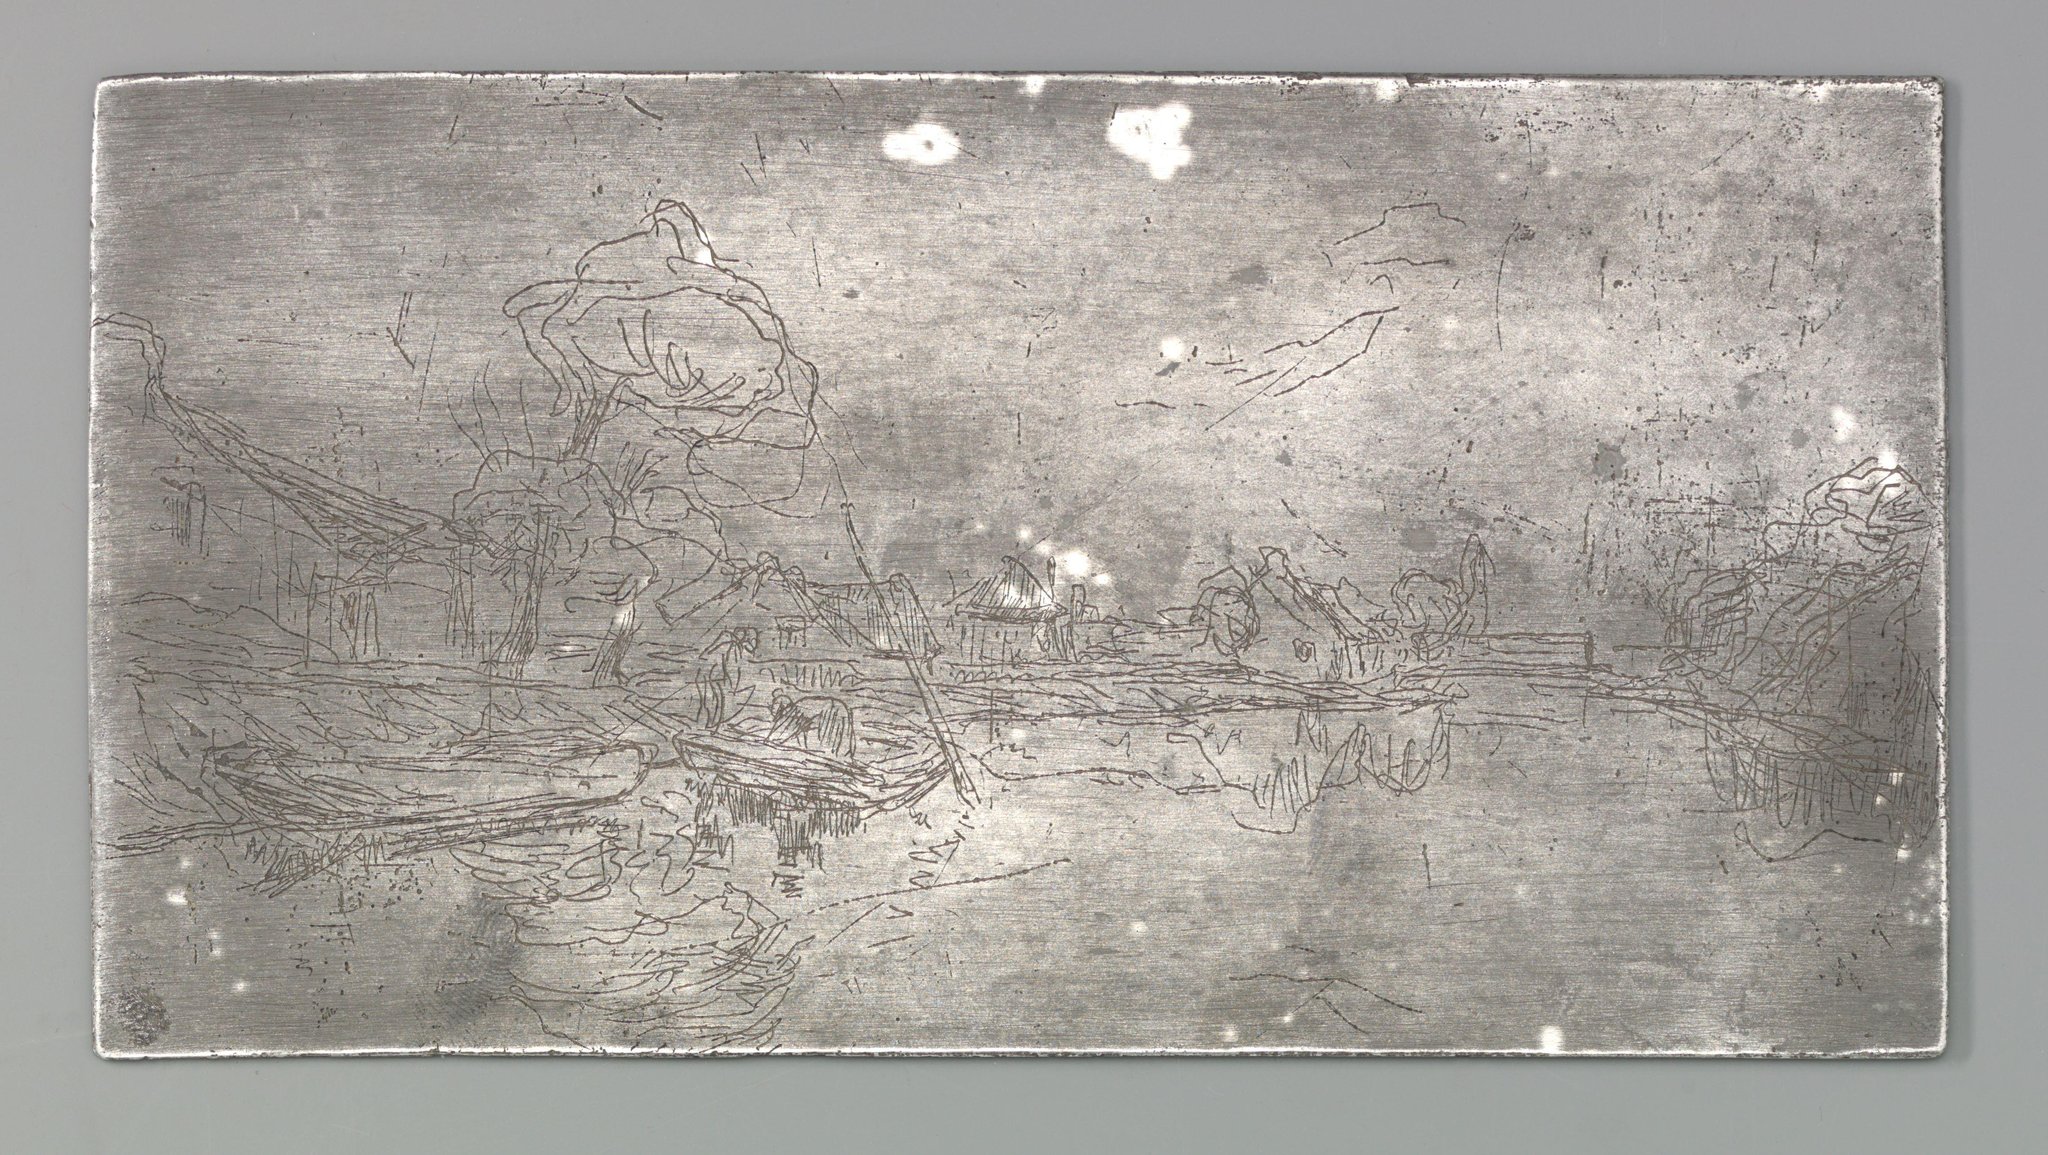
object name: zinkplaat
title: Noorden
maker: floris verster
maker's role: draughtsman, painter, print maker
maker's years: 1861-1927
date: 1890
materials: zinc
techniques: etching